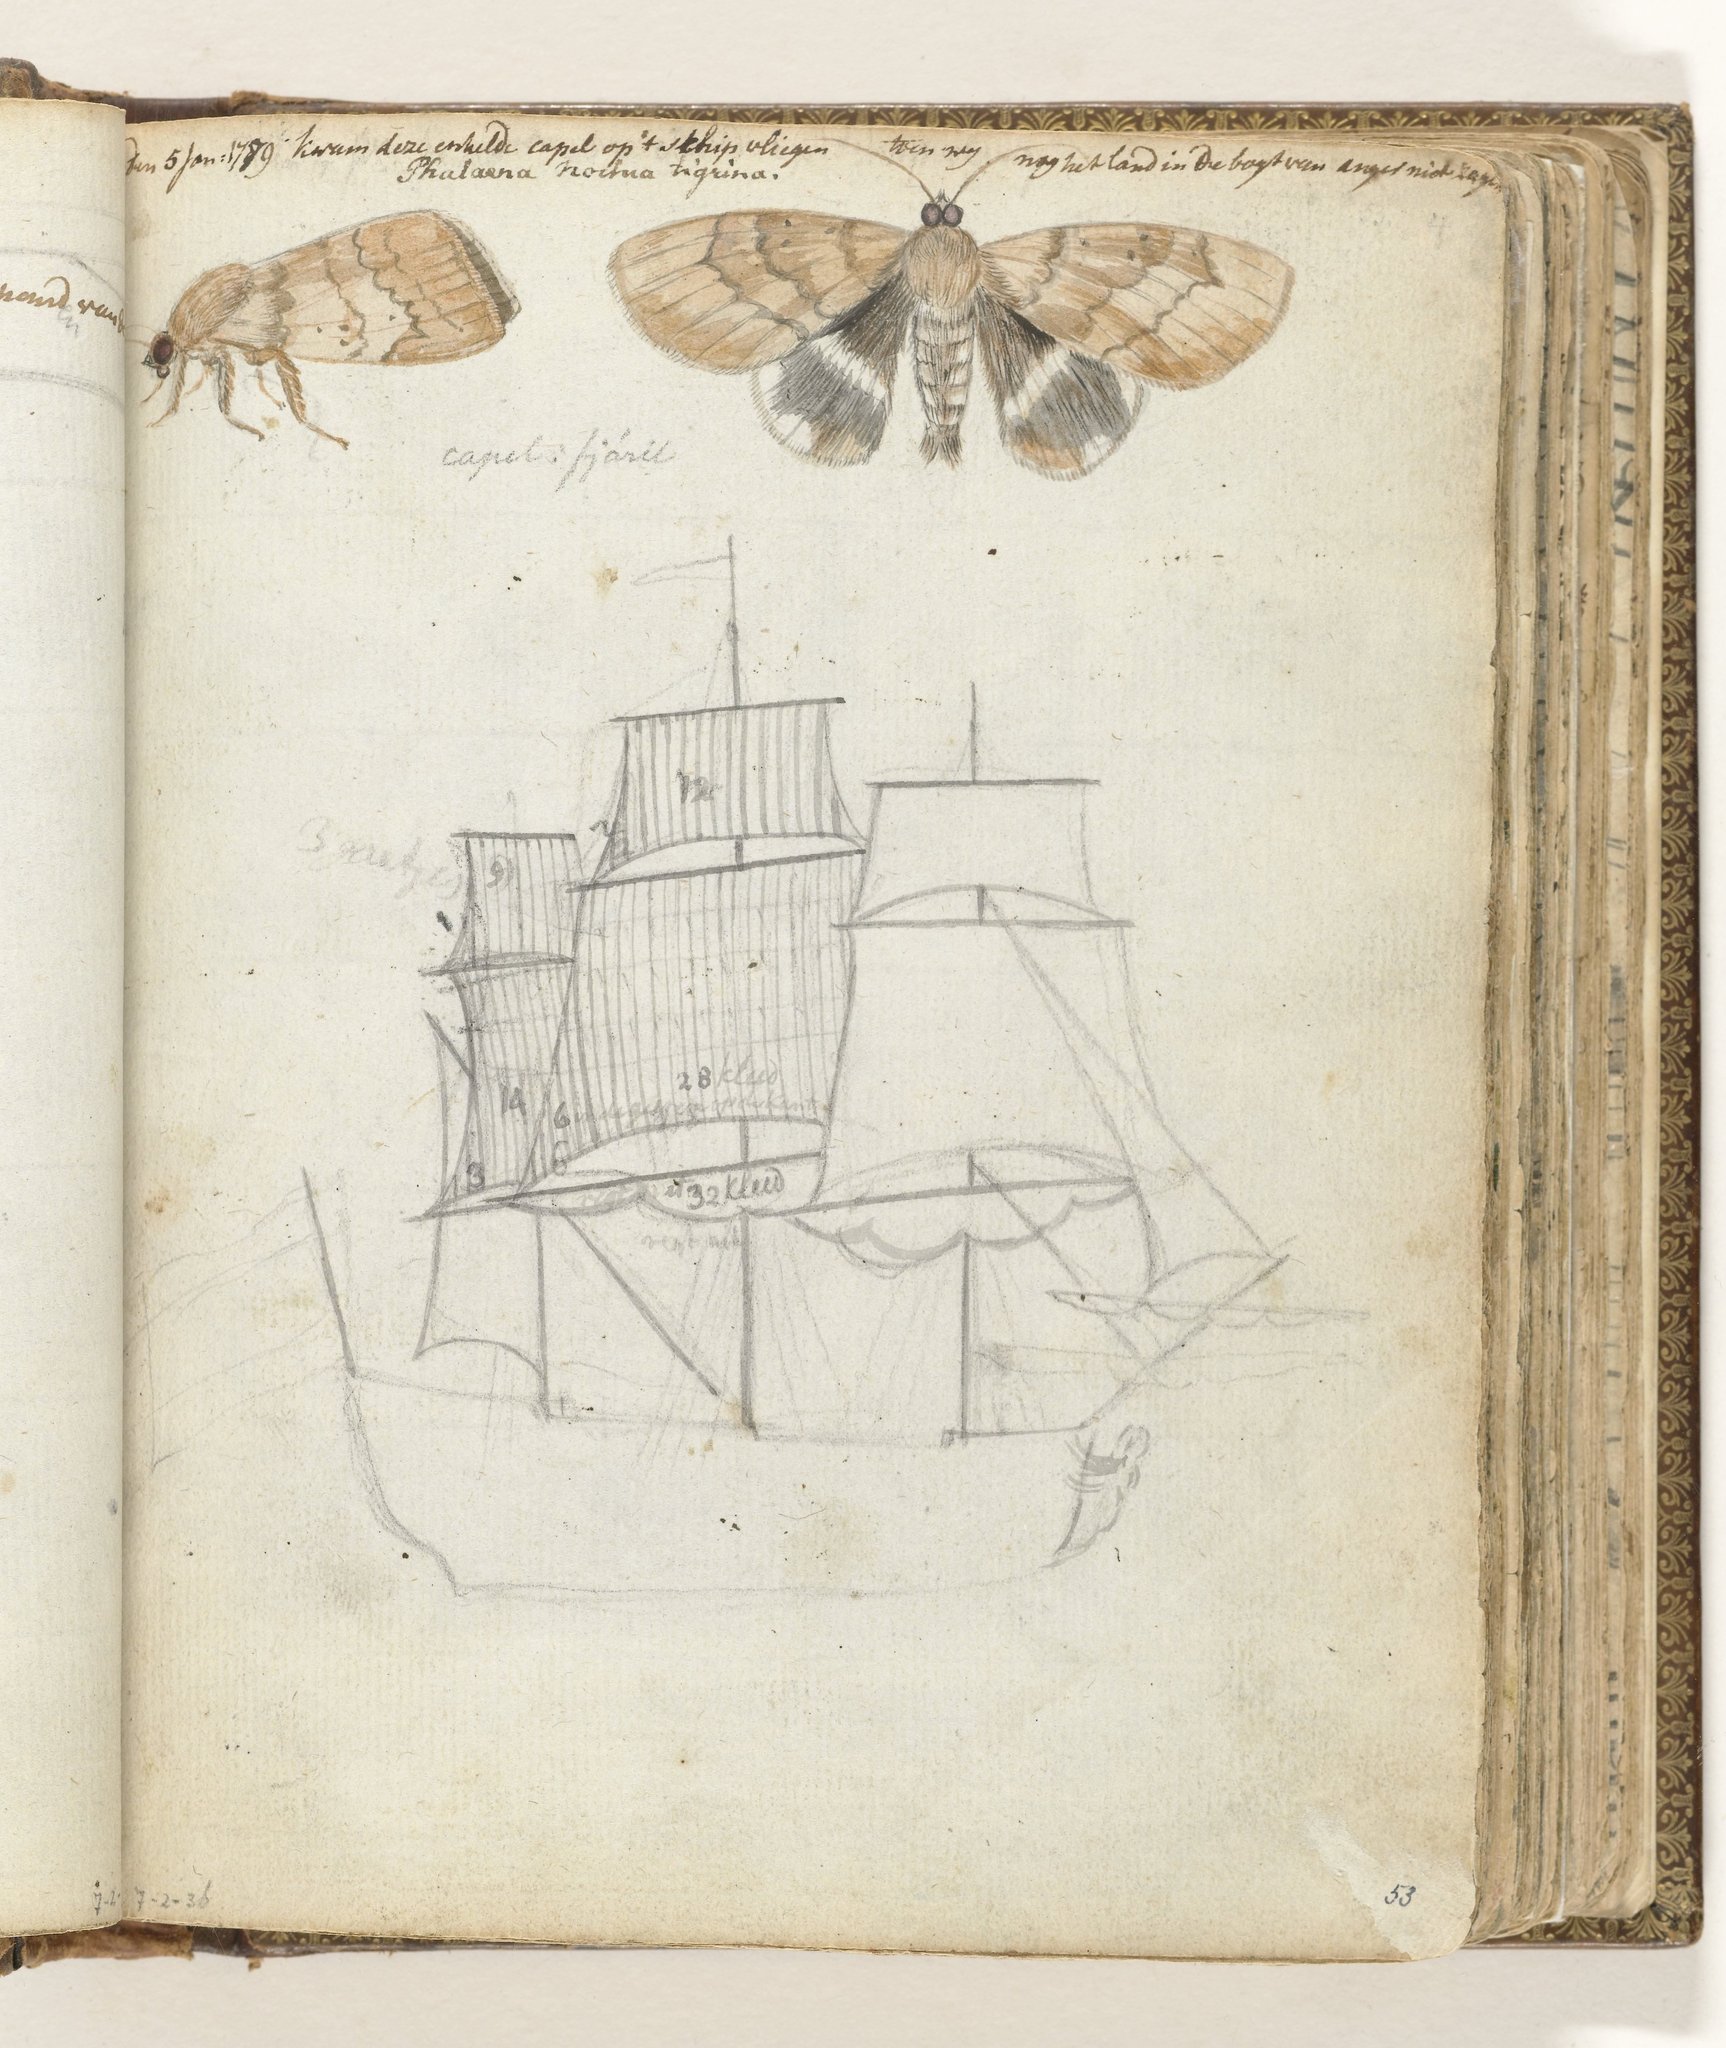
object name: drawing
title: Vlinder en schip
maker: jan brandes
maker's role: draughtsman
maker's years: 1743-1808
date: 1779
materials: paper, pencil, watercolor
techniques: brush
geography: java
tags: sailing-ship, sailing-boat, insects: moth, insects: butterfly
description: Kleurtekening van een vlinder of mot, van boven en opzij. Schets van een schip met afmetingen van de zeilen. Met opschrift. Onderdeel uit het schetsboek van Jan Brandes, dl. 2 (1808), p. 53.